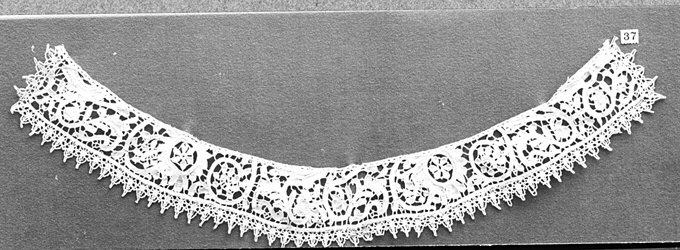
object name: fragment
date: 1601-1700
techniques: lace